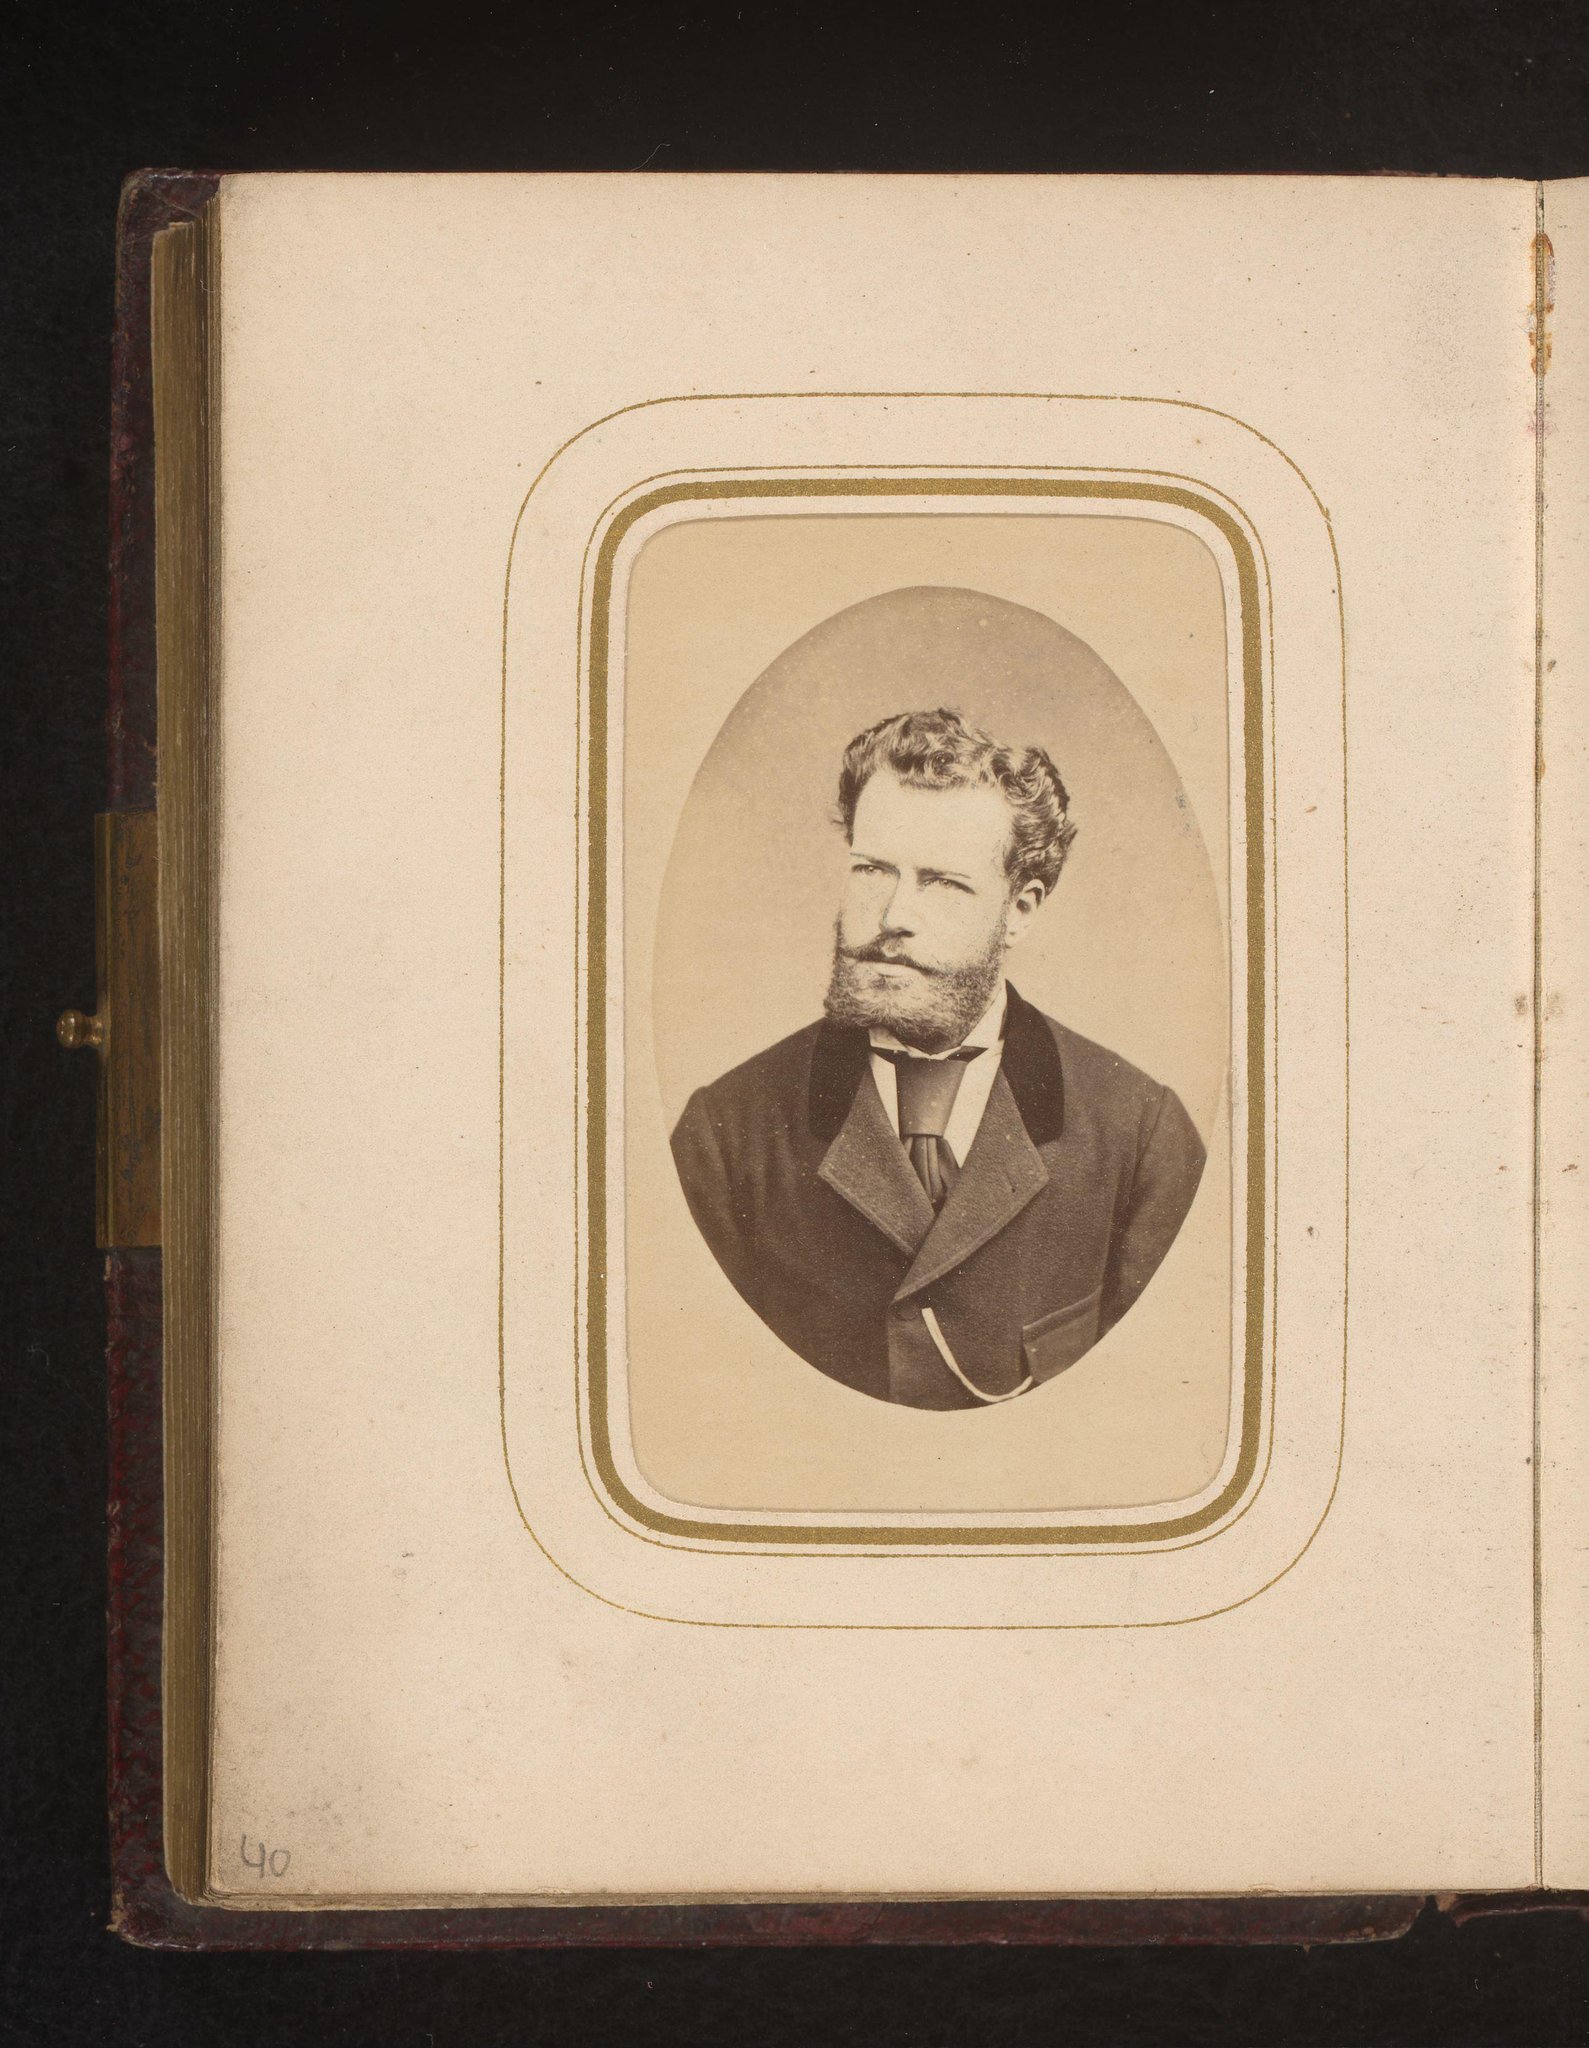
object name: album leaf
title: Portret van een man met baard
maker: Anonymous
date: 1860-1900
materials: cardboard, photographic support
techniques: albumen print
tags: historical persons, beard